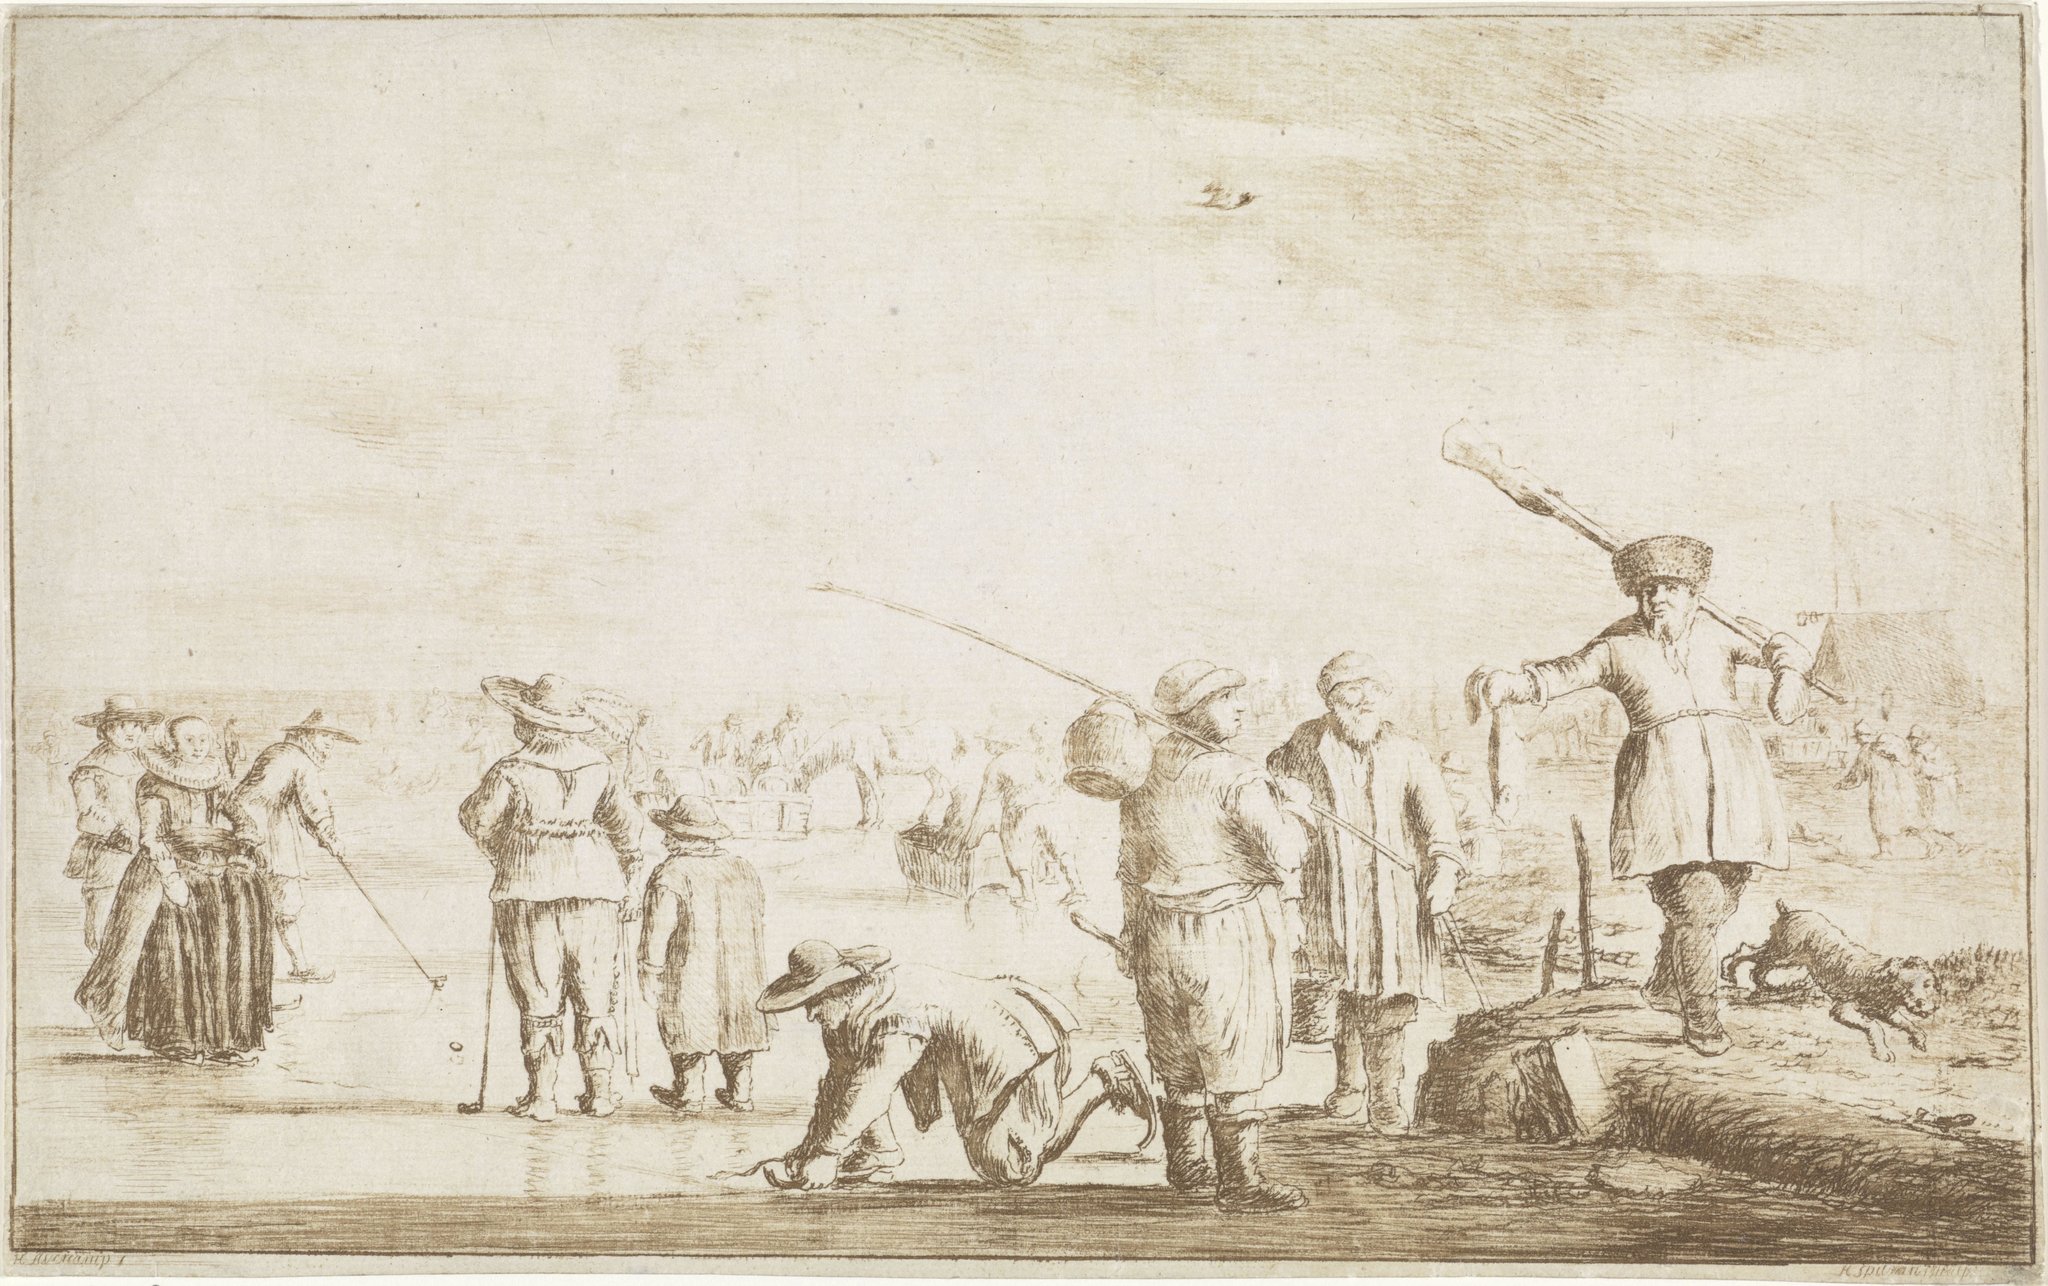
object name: print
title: IJsgezicht met jager die een otter toont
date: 1742-1784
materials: paper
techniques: aquatint, etching, roulette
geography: haarlem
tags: beasts of prey, predatory animals: otter (+ animal killed by man), hunter, skates (winter sports), 'kolf' on the ice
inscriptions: collector's mark: Lugt 2228